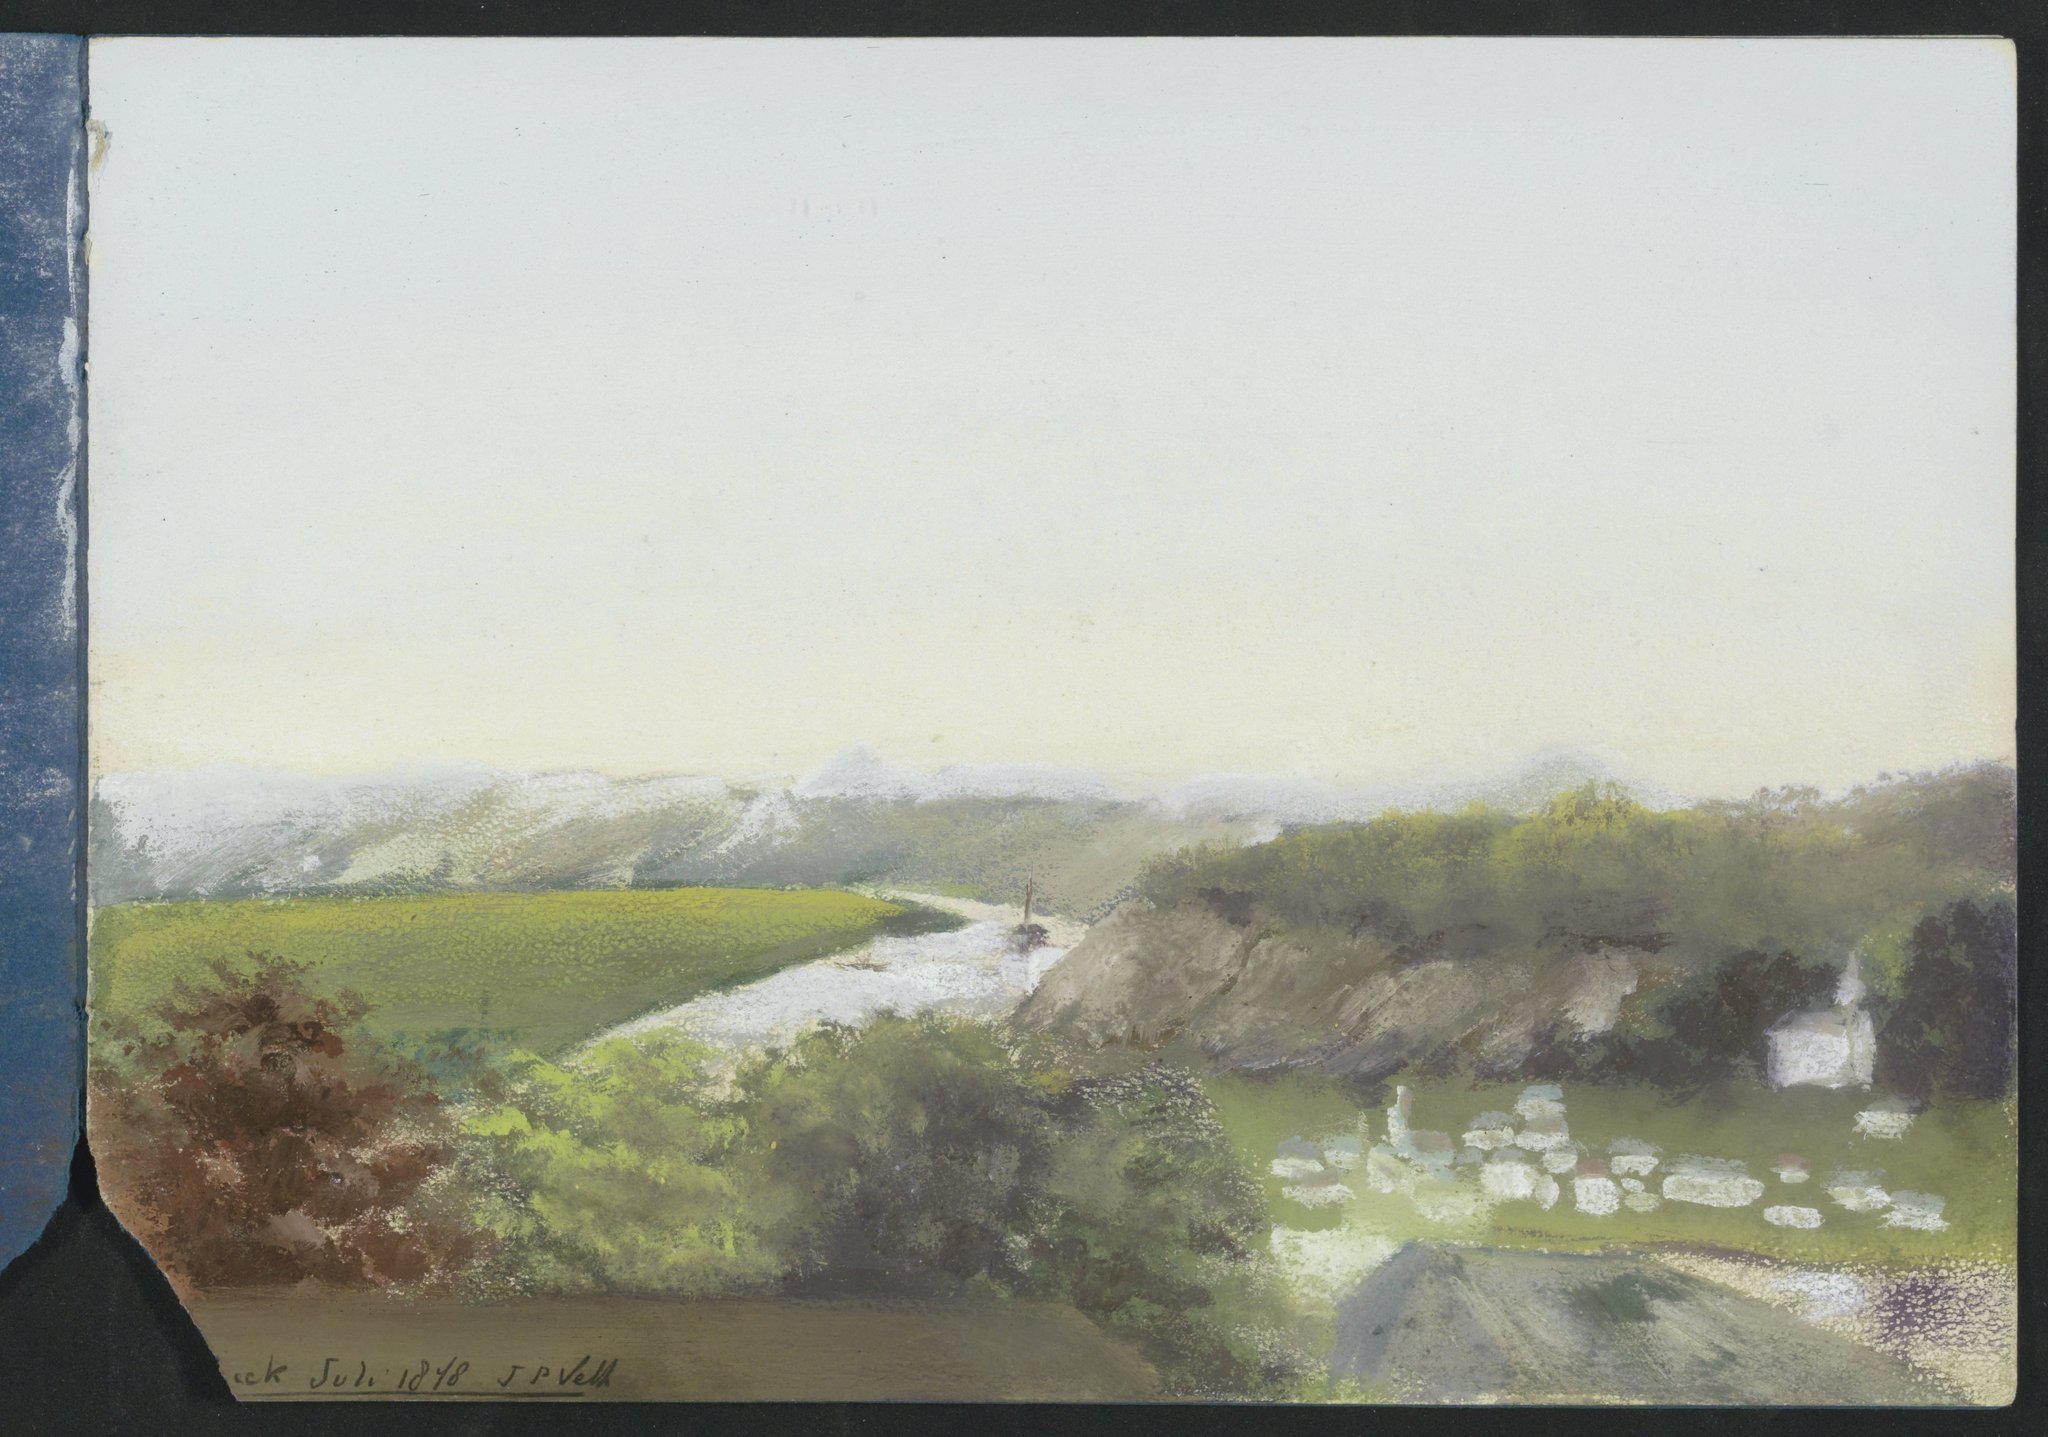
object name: sketchbook leaf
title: Berglandschap met een rivier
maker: jan veth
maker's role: designer, draughtsman, painter, print maker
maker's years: 1864-1925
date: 1807-1878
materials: paper, watercolor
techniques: brush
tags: river, landscapes with waters, waterscapes, seascapes (in the temperate zone), mountain-range, snow peaks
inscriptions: signature and date: ‘[...] ick Juli 1878 J.P. Veth’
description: De toppen van de bergen zijn besneeuwd. Op de rivier een zeilschip. Blad 2 recto uit een schetsboek met 4 bladen.